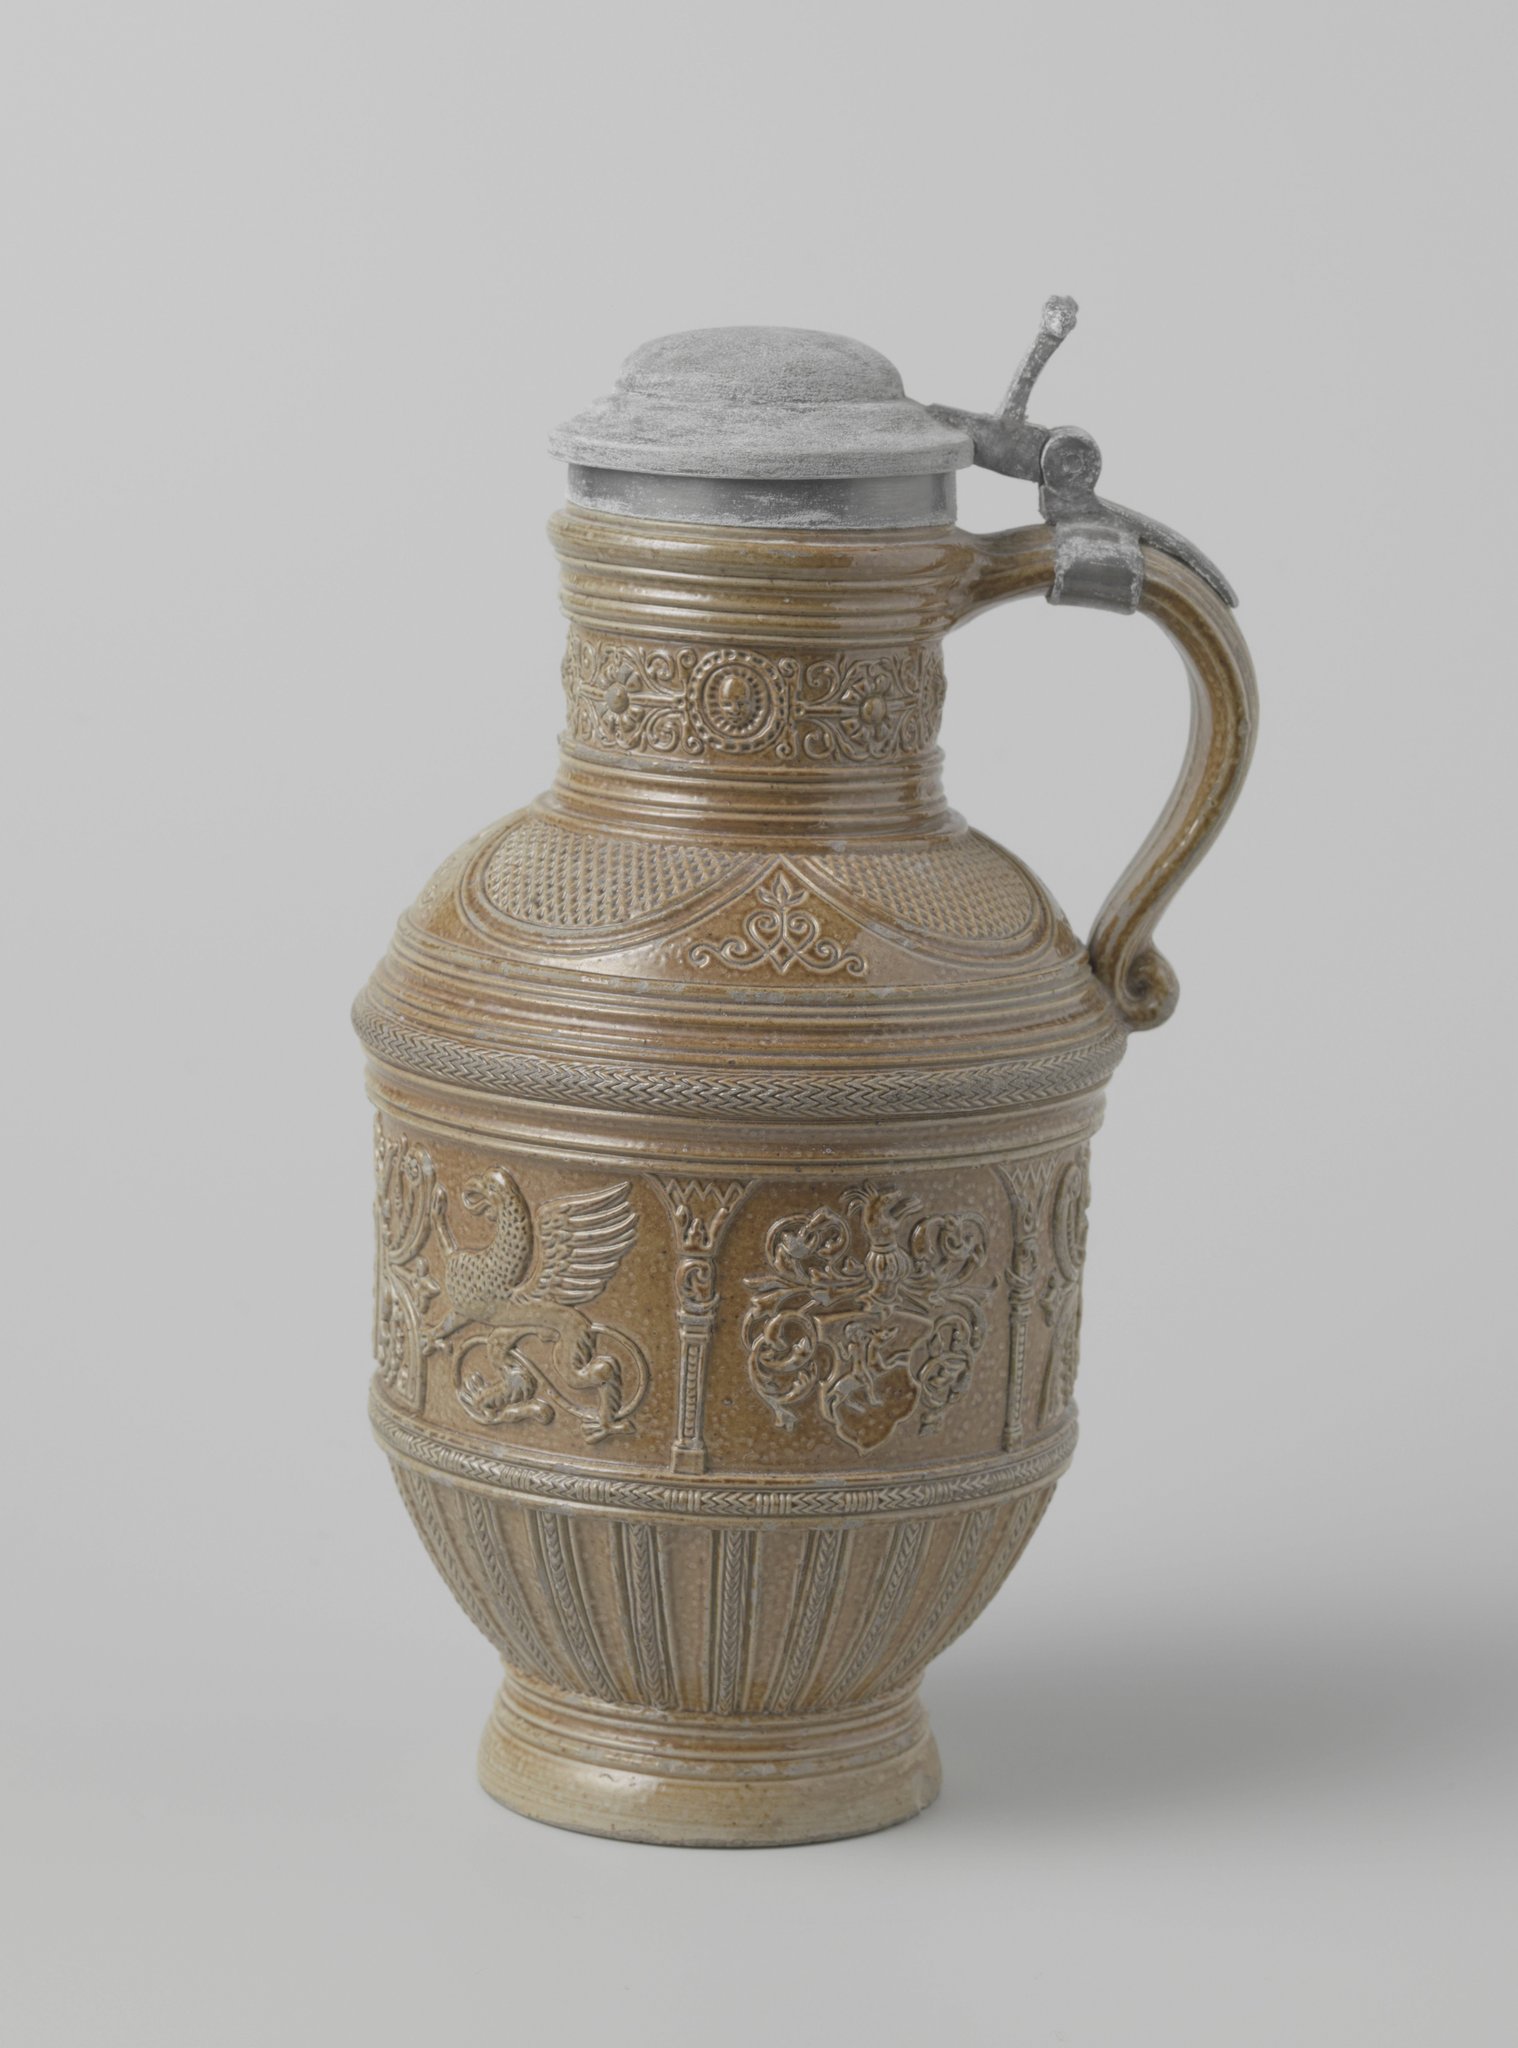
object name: jug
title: Jug with the coat of arms of Amsterdam and Saxony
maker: hubert schiffer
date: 1860-1880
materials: engobe, glaze, stoneware, tin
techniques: printing, firing, forming, relief, turning, vitrification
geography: raeren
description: Kruik van steengoed op hoge voet met een cilindrisch lichaam, ronde schouder en wijde, geribde nek. Profielen op het lichaam en de voet. Bedekt met een bruine engobe. Op de buik in reliëf een gedrukte en opgelegde band, door pilasters verdeeld in vakken waarin afwisselend het wapen van Amsterdam, geflankeerd door griffioenen, en het wapen van Saksen. Het onderste deel van de buik loopt schuin af naar de voet en heeft canelures. Op de schouder halfronde vakken met kerfsnede waartussen een gestempelde, gestileerde bloemrank. De nek met een band bloemranken onderbroken door maskers in een medaillon. Bevestigd aan het oor een tinnen montuur met deksel. Kopie gebaseerd op het 16e eeuwse Raerense type. Raeren.